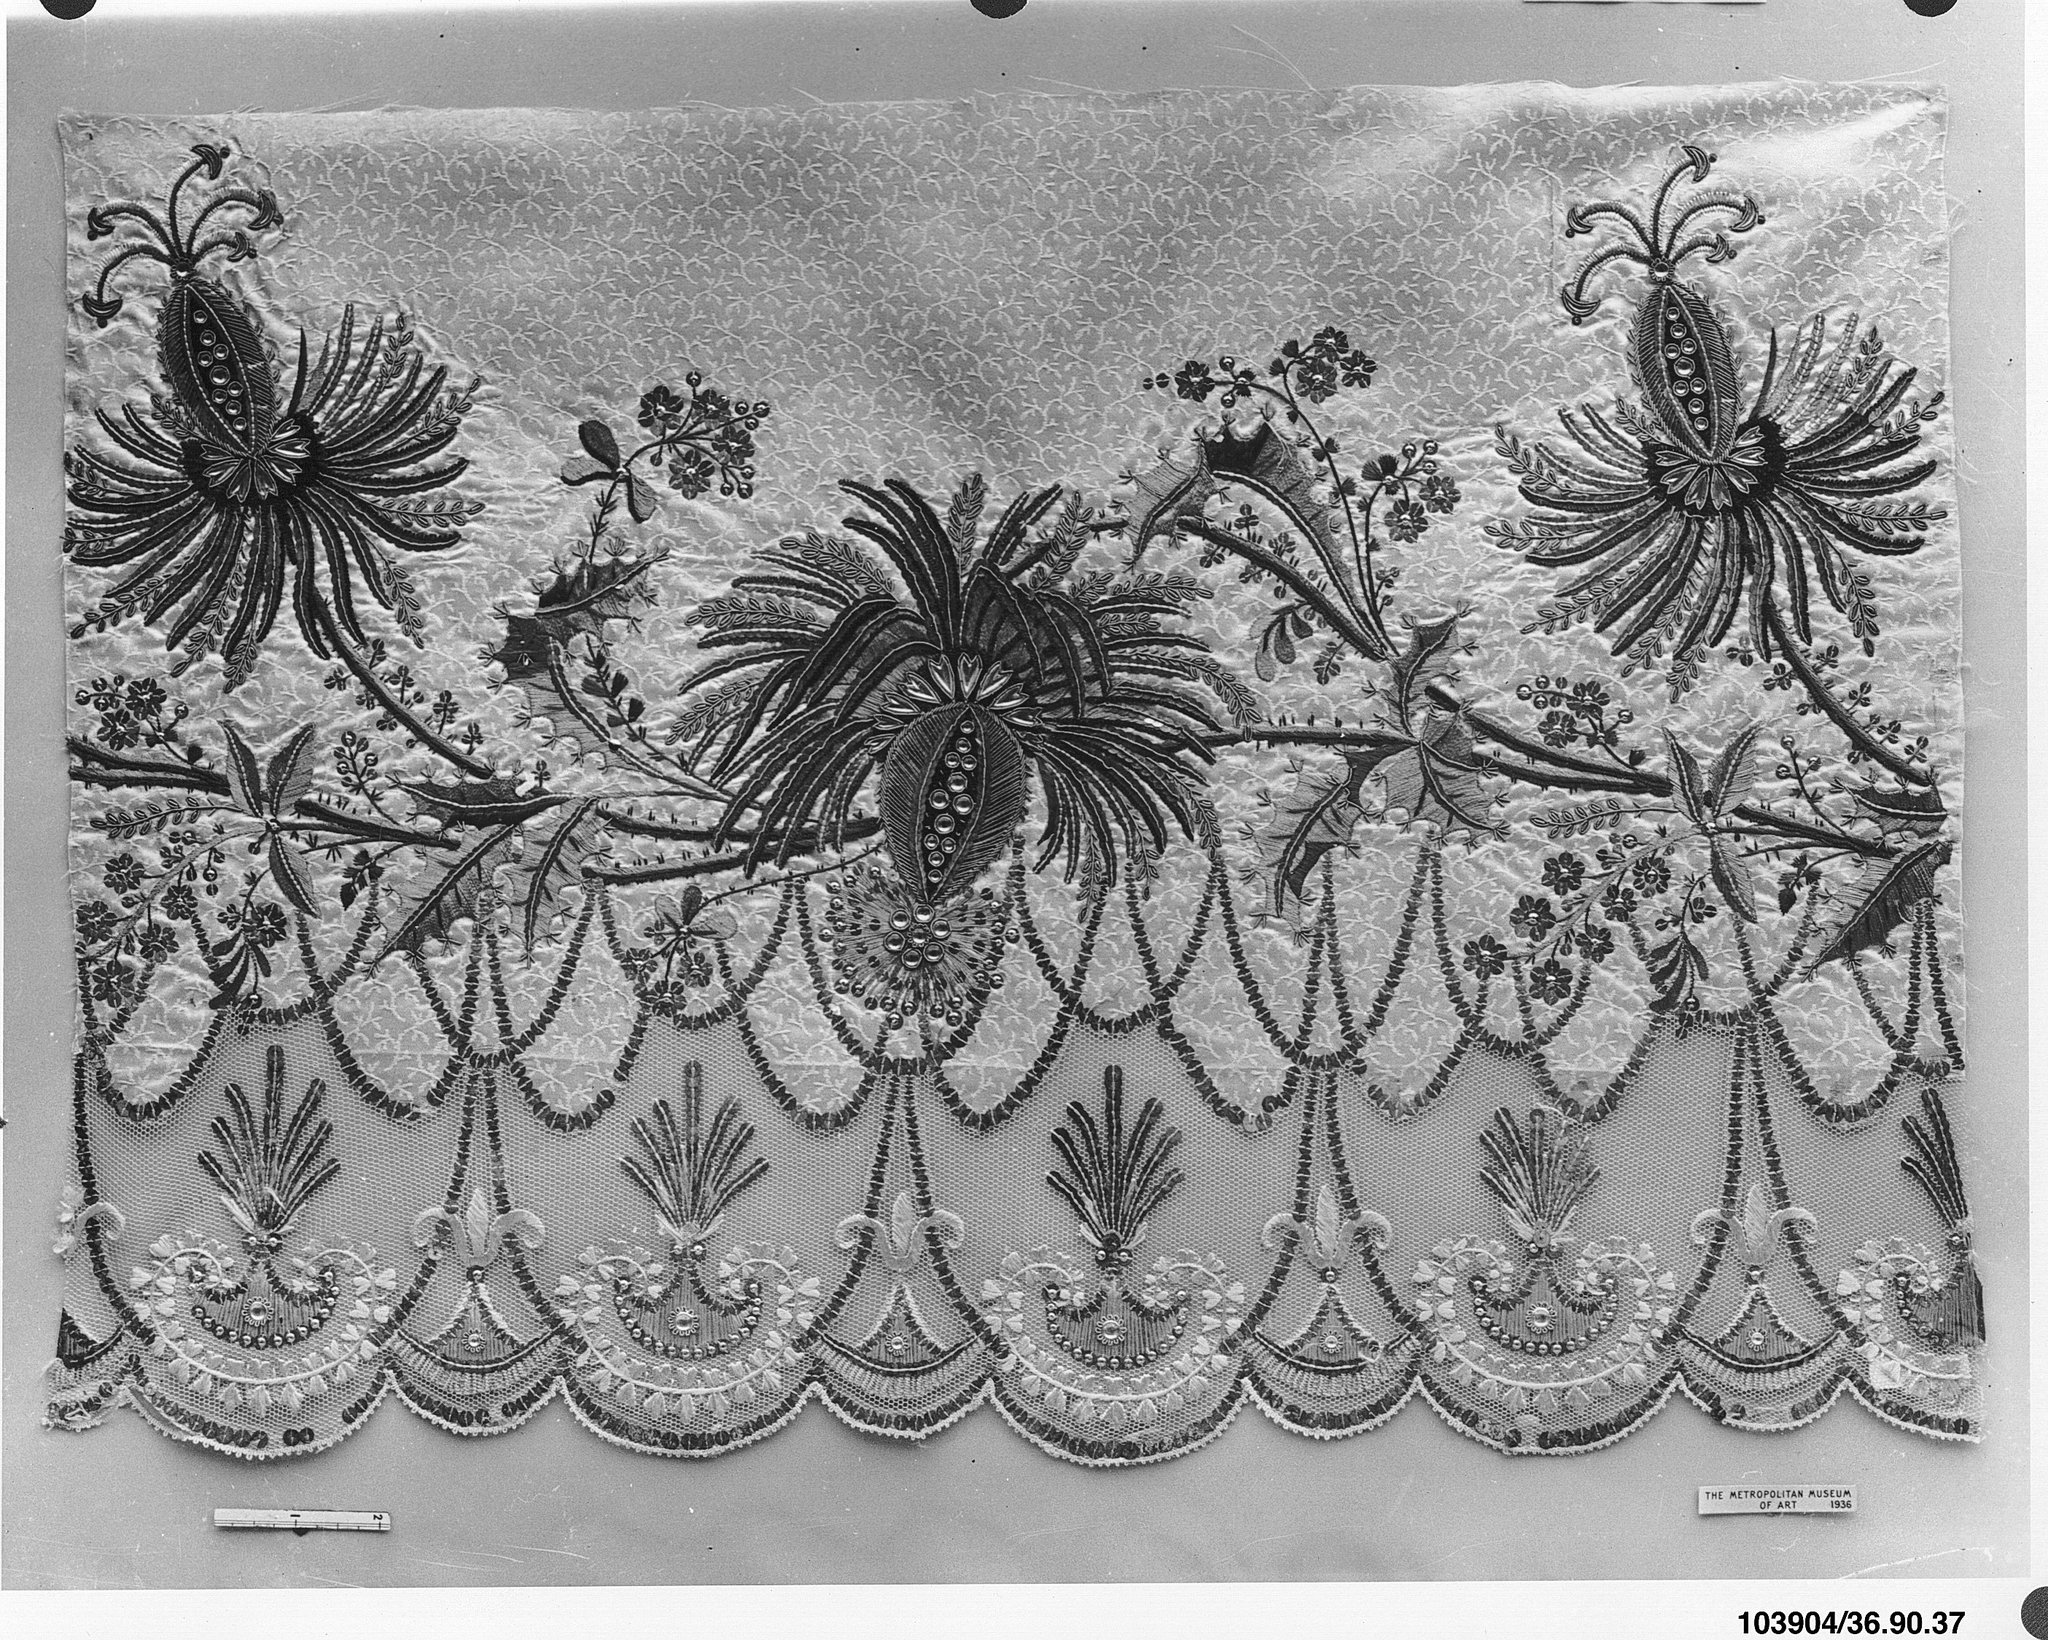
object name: border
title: Dress border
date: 1801-1833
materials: metal thread, silk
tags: flowers